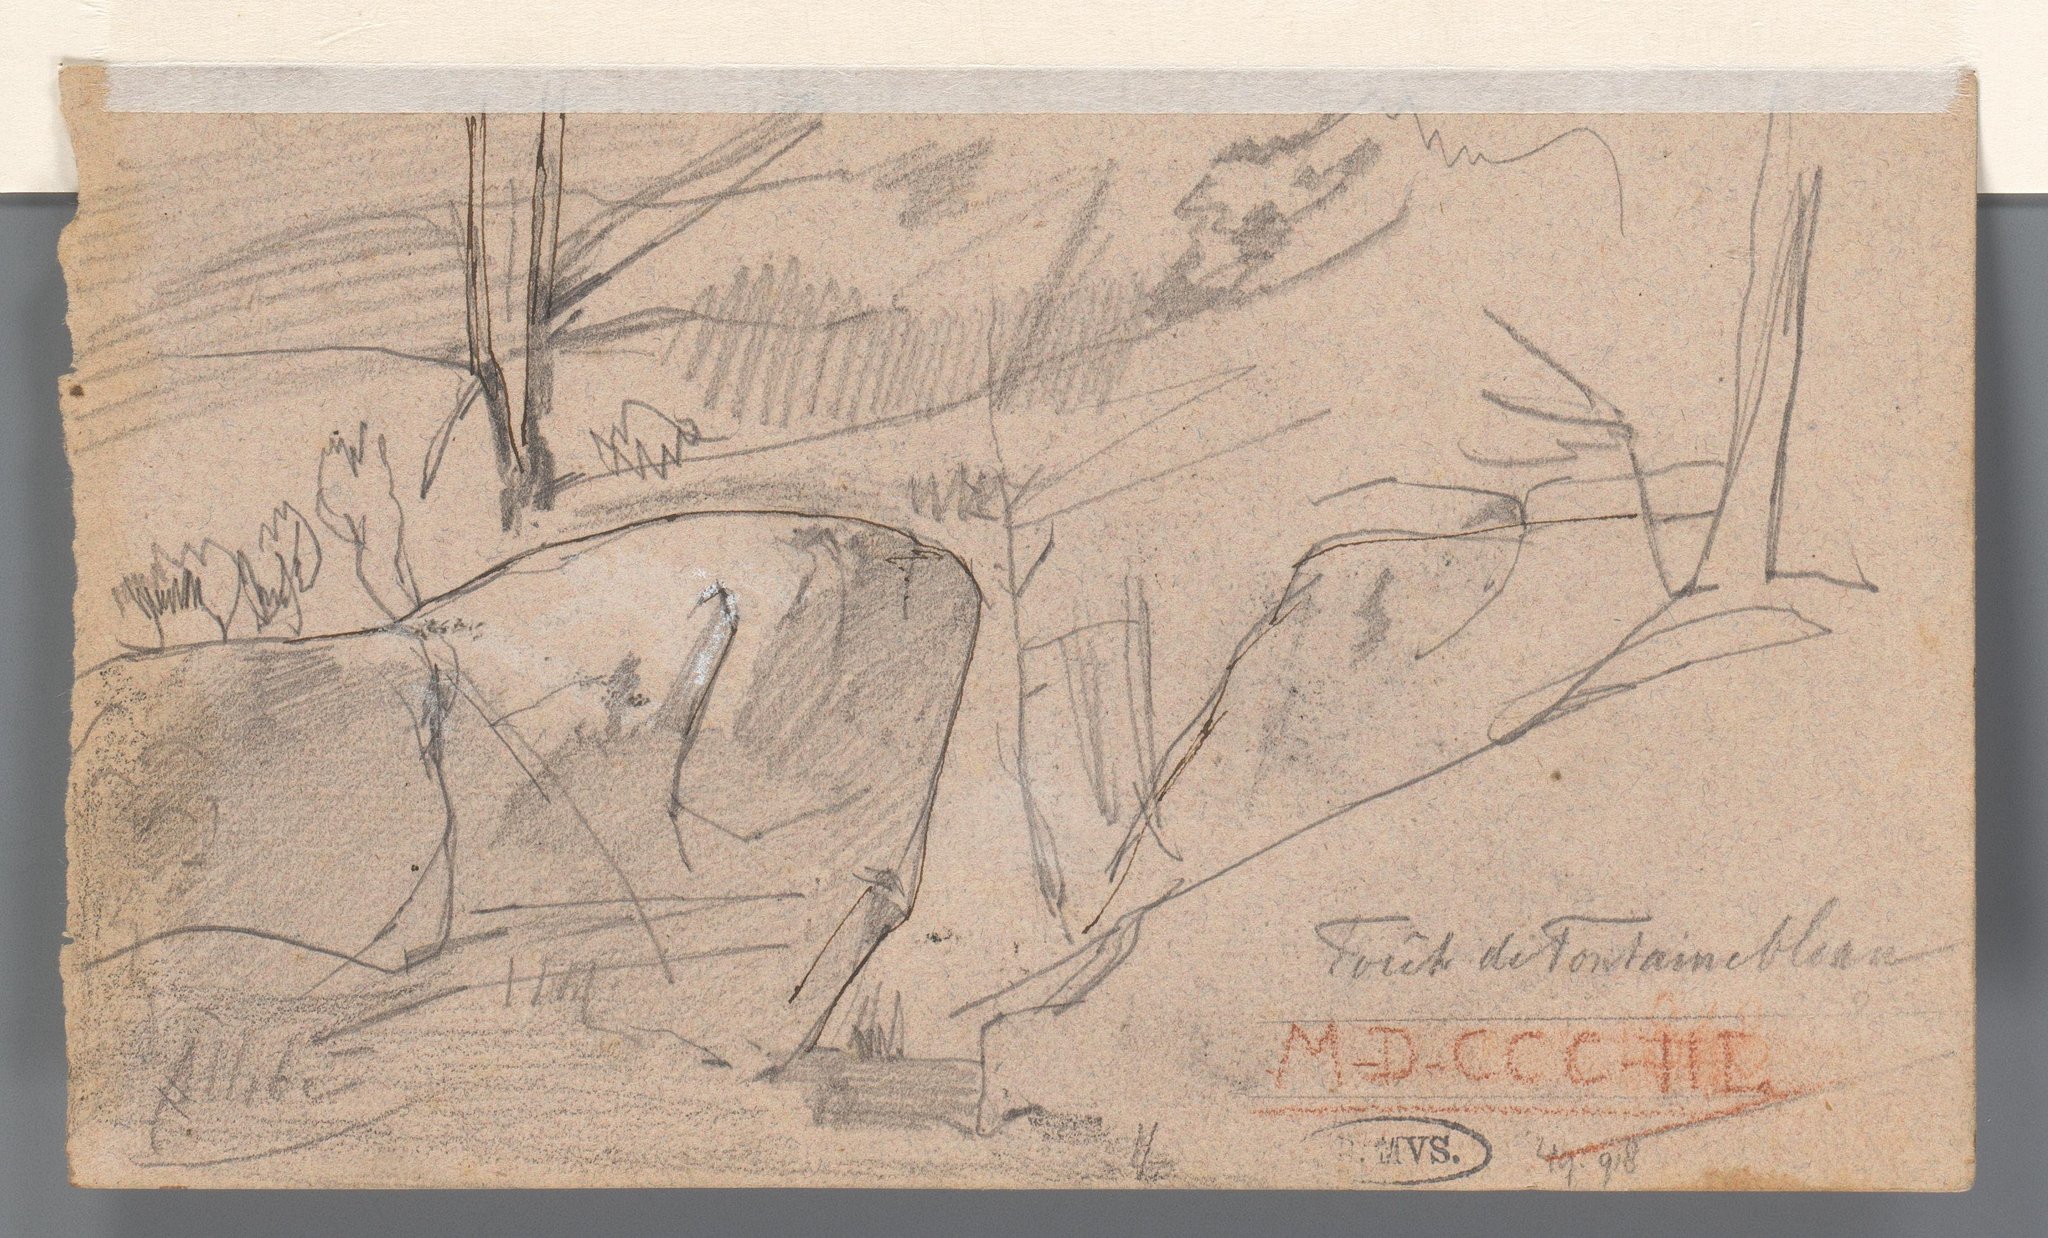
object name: drawing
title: Bos te Fontainebleau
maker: august allebé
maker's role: draughtsman, print maker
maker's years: 1838-1927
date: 1848-1927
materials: paper, pencil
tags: forest, wood